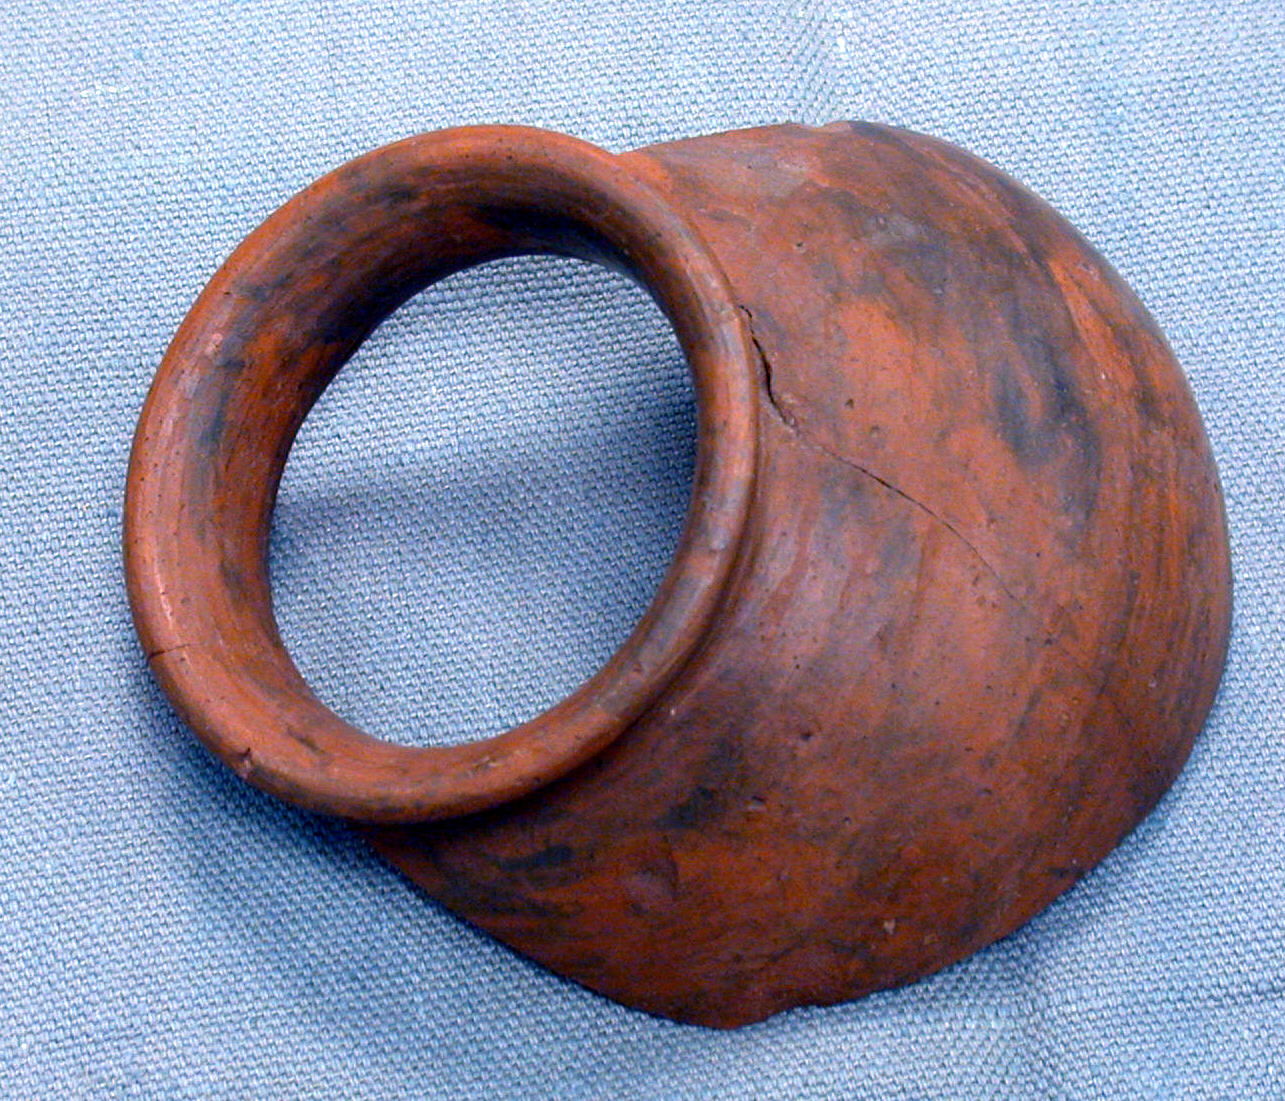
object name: jar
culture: sasanian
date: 201-700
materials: ceramic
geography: iran